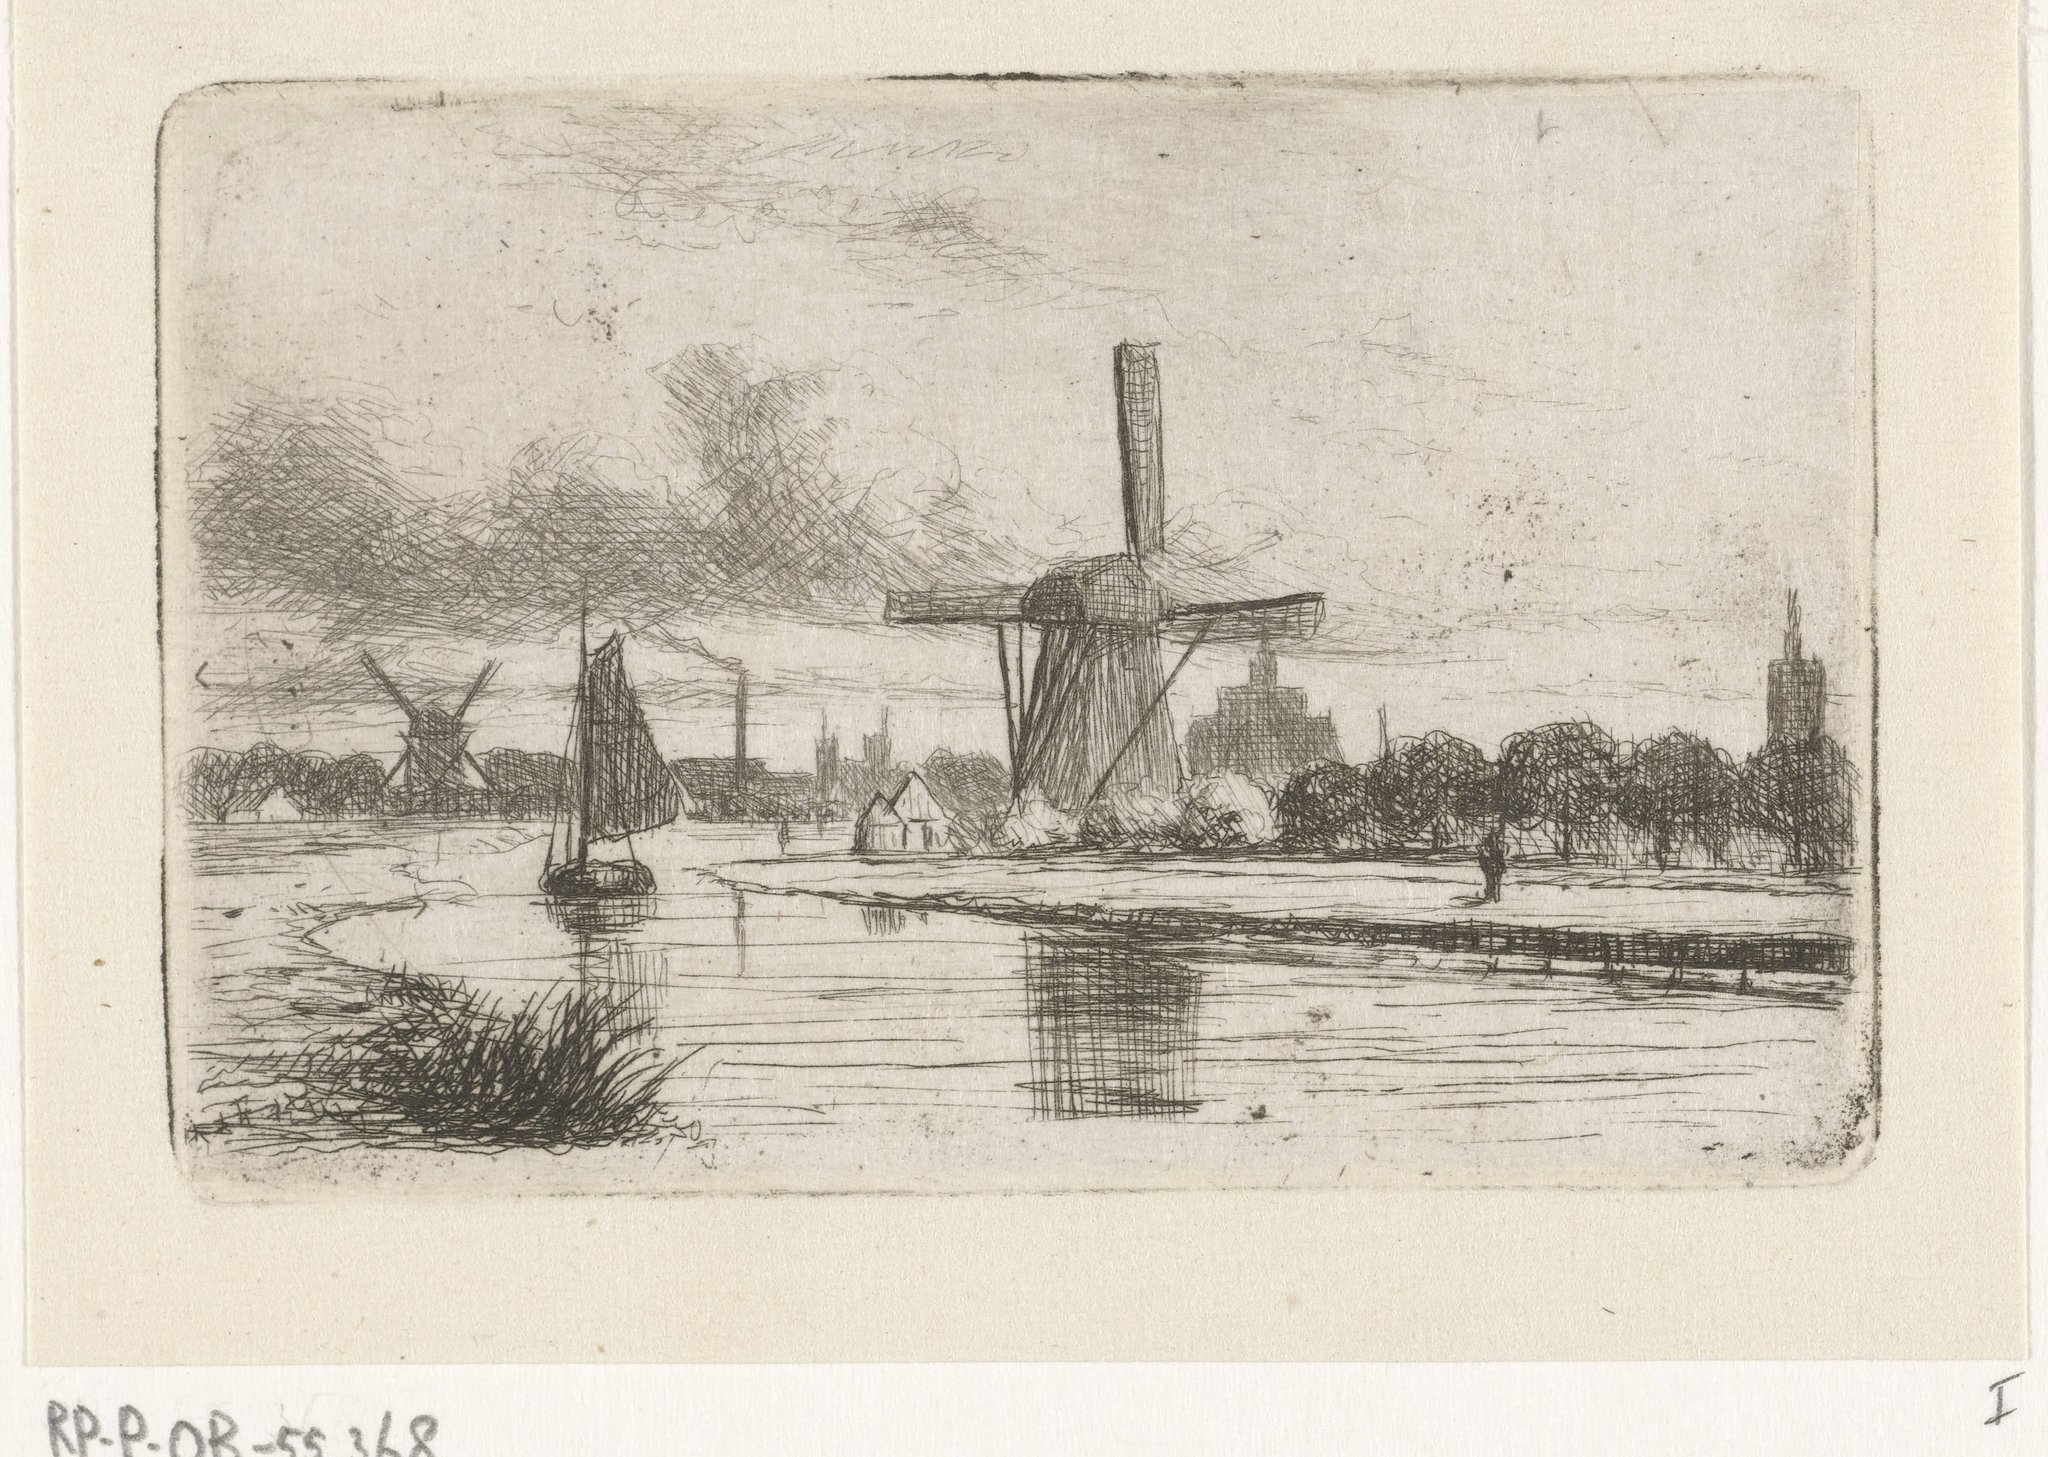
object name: print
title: Rivierlandschap met molens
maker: jan heppener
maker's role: print maker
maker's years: 1826-1898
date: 1841-1898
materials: paper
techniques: etching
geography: the hague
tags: landscapes with waters, waterscapes, seascapes (in the temperate zone), windmill in landscape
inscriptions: collector's mark: Lugt 2228